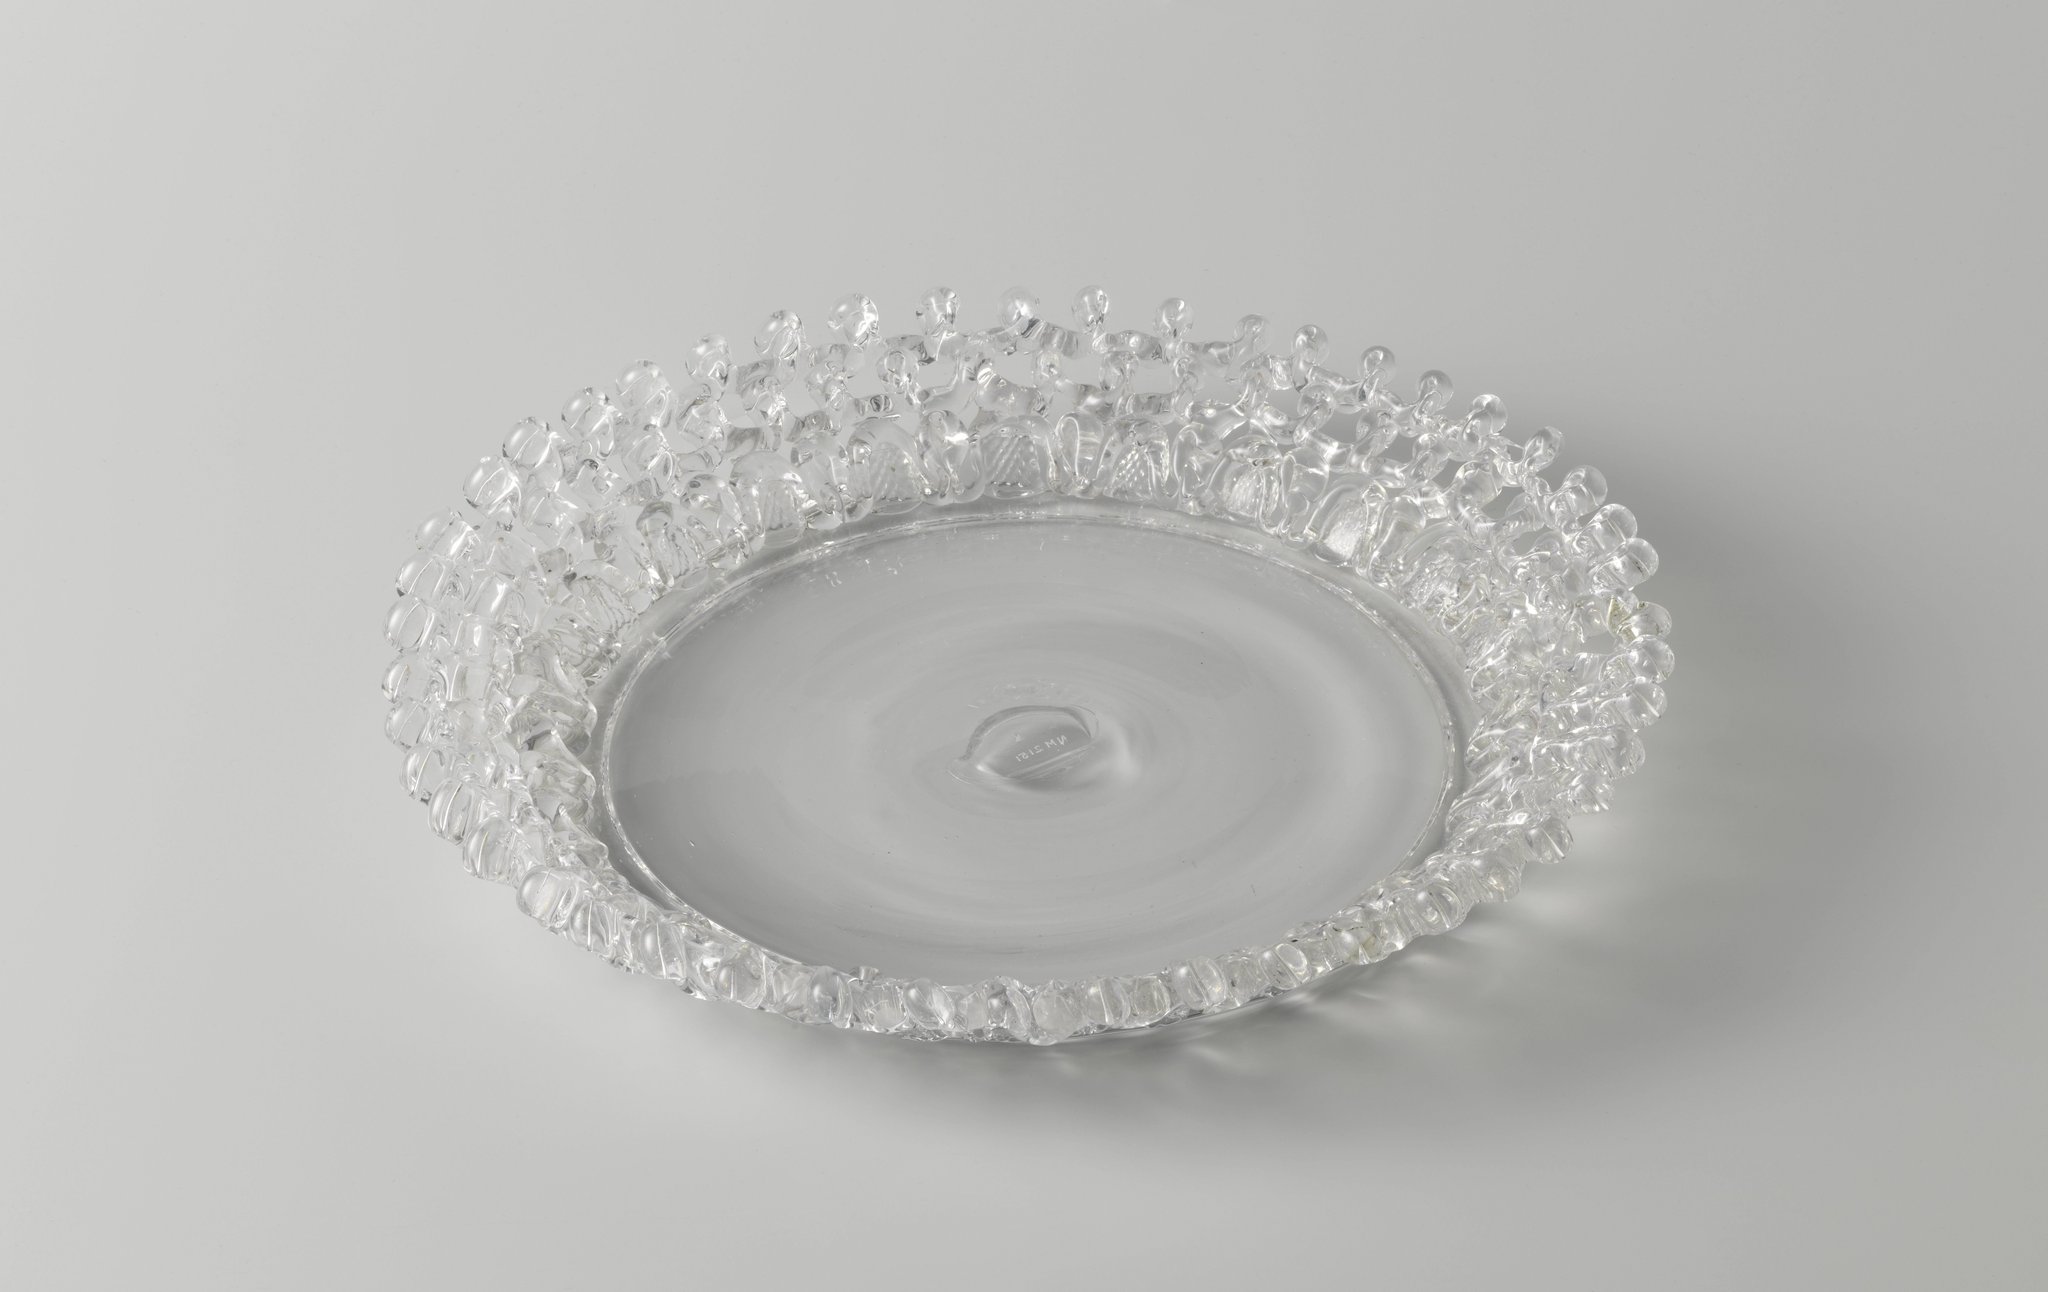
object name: platter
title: Onderschotel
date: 1750-1800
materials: glass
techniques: glassblowing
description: Gladde bodem, opstaande rand van gladde draden in een filetpatroon, afgezet met een dikke, gekartelde draad. Horend bij mand (BK-NM-2151-2).